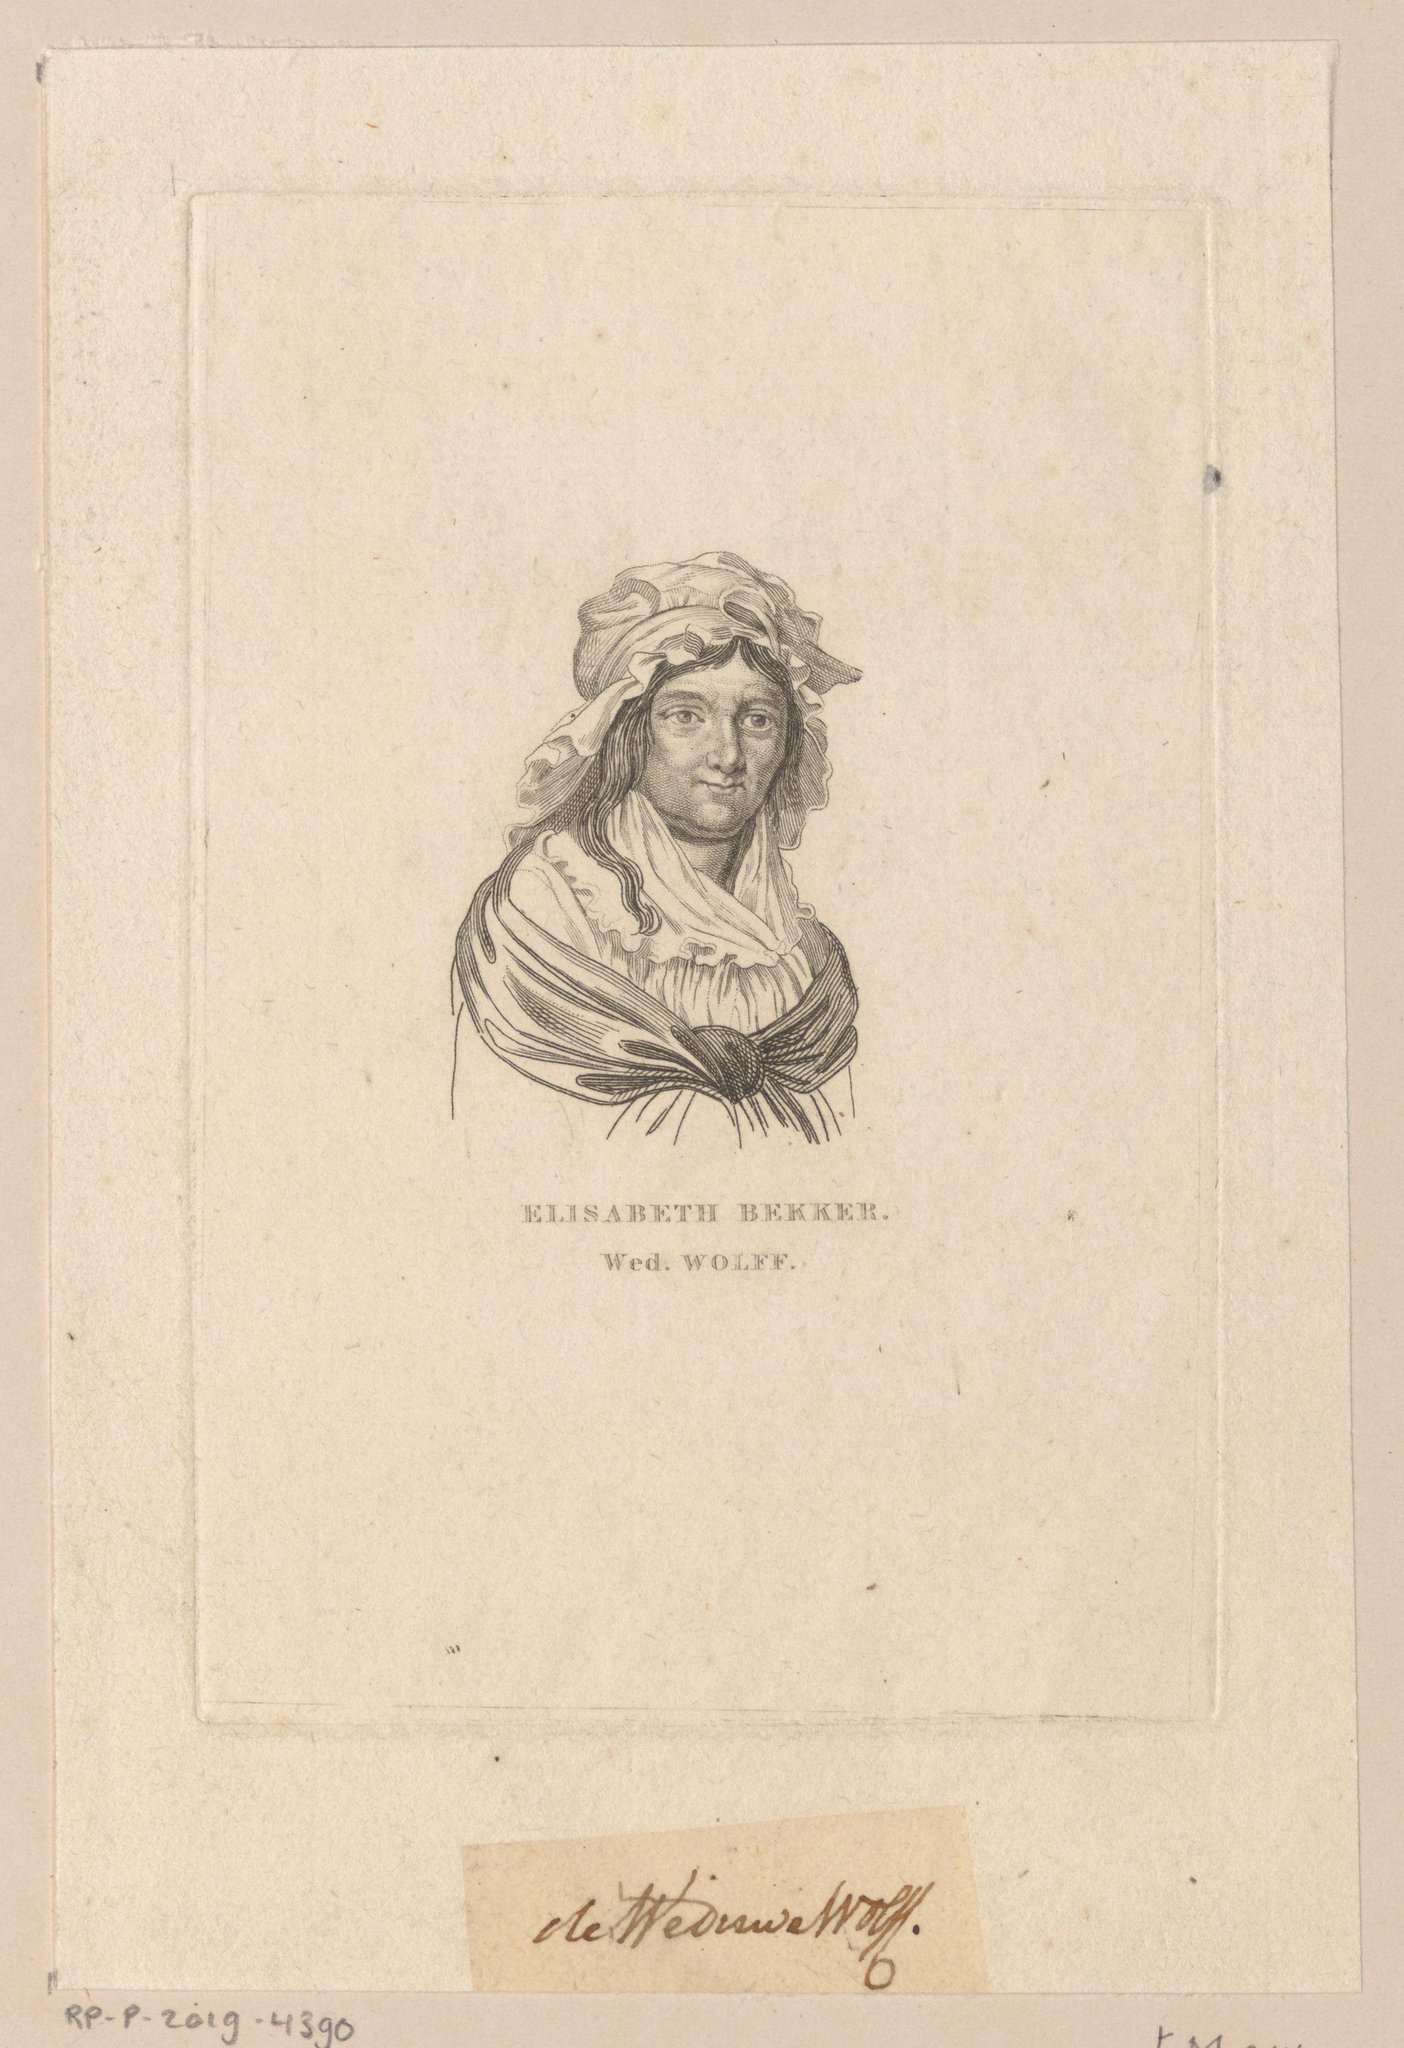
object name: print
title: Portret van Elisabeth Wolff-Bekker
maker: Anonymous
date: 1777-1825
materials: paper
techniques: engraving, etching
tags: flushing, the hague, elisabeth bekker, historical persons - bb - woman, portrait of a writer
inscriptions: inscription: ‘de Weduwe Wolff.’